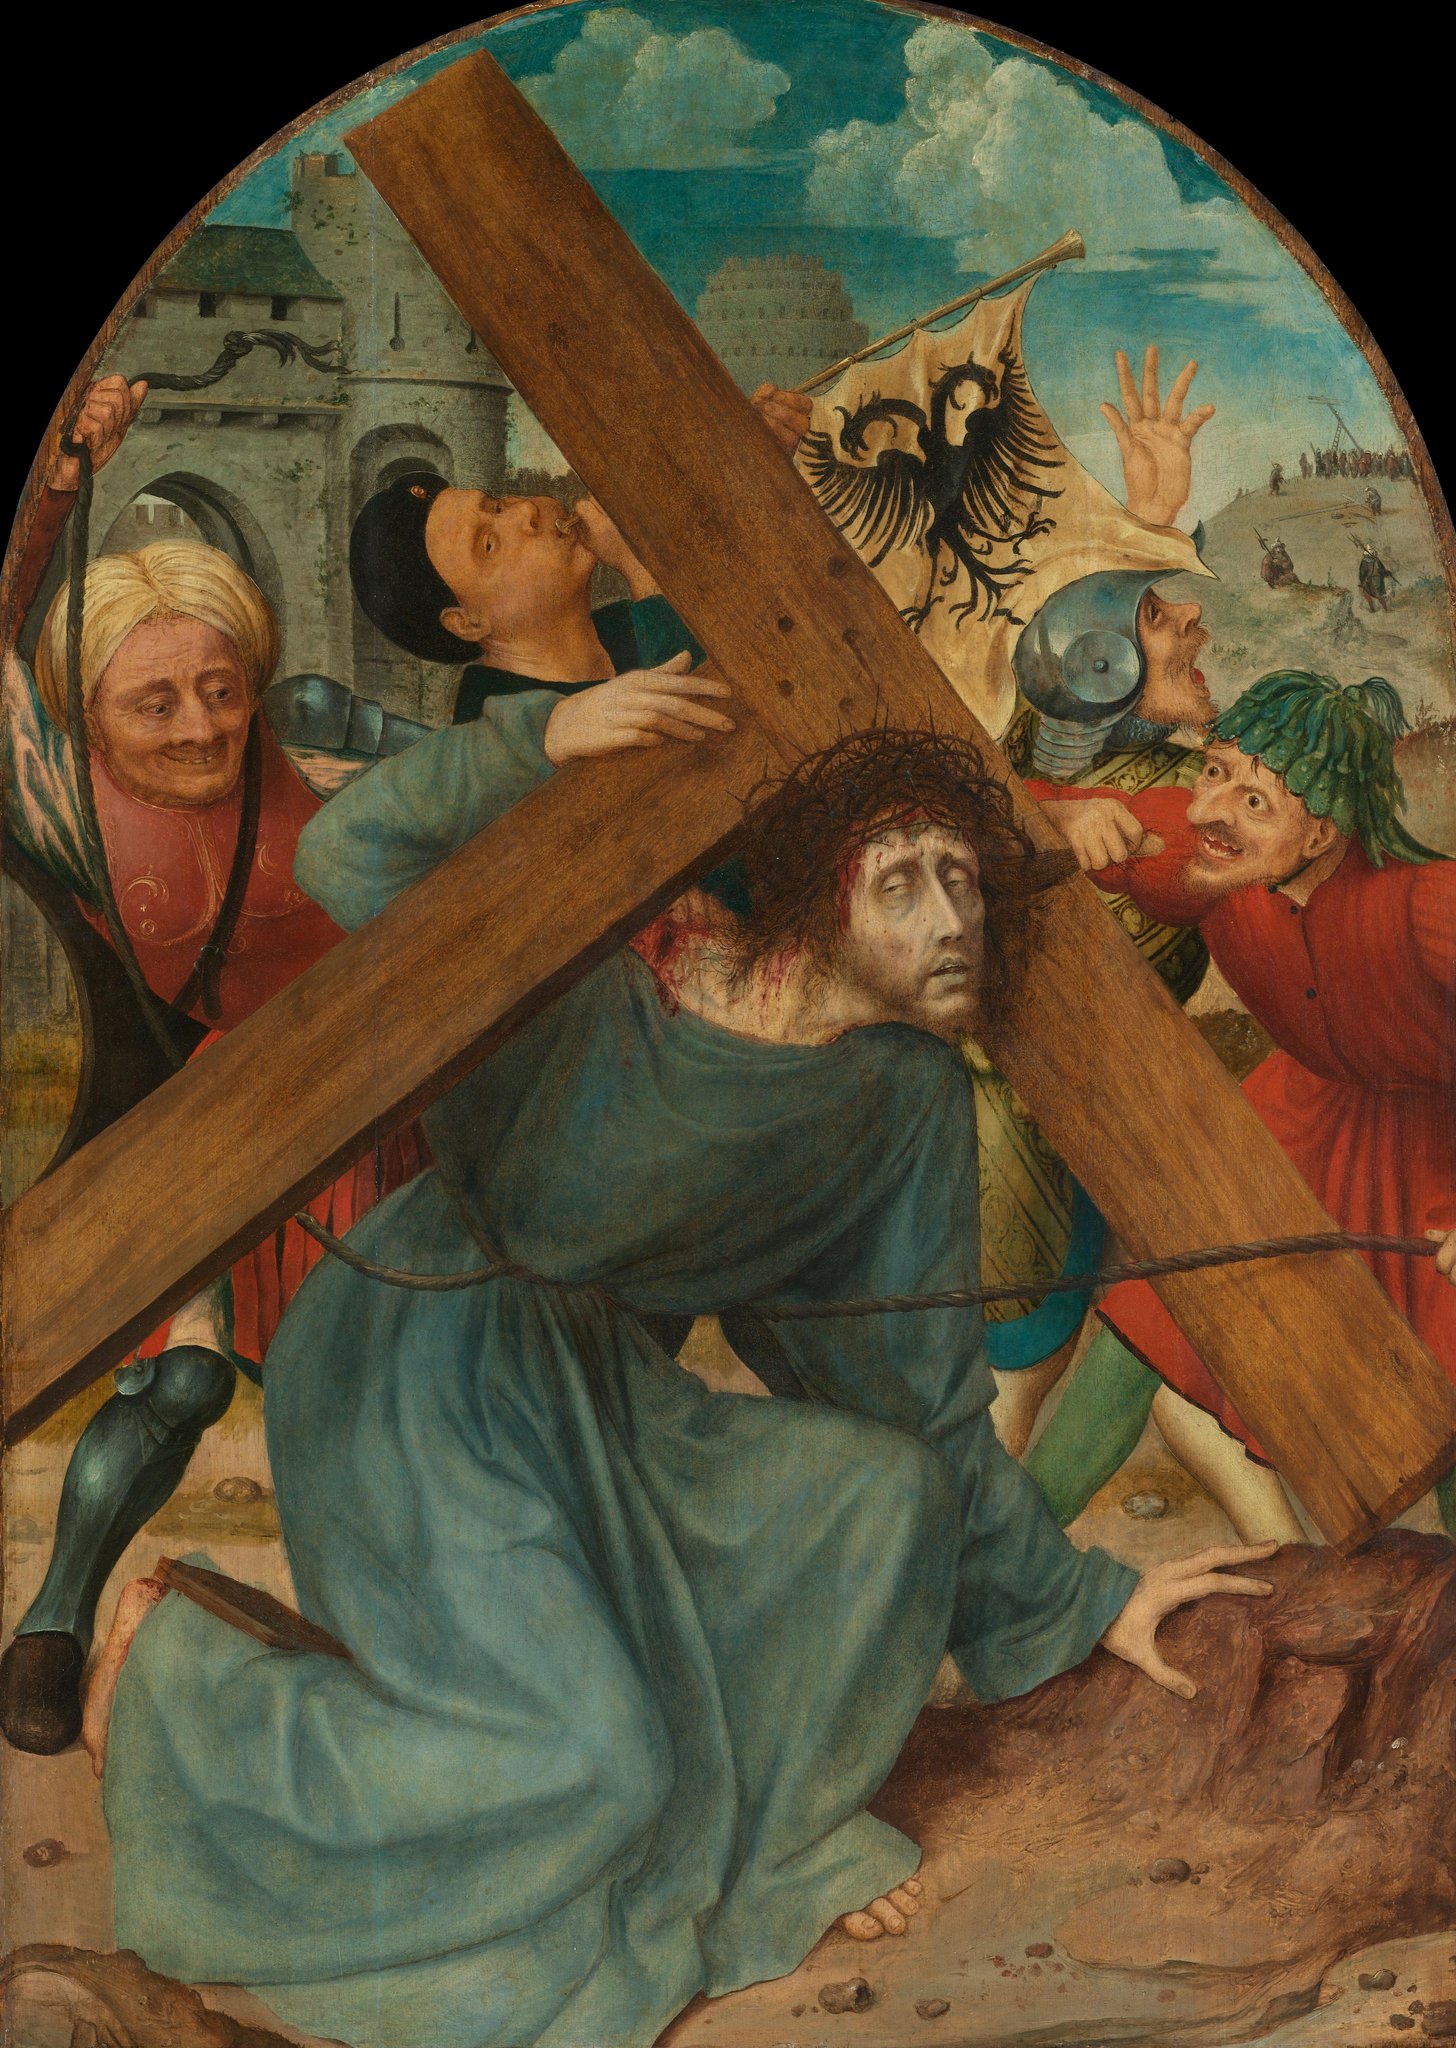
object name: painting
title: Christ Carrying the Cross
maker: quinten massijs (i)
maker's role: draughtsman, painter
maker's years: 1466-1530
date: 1510-1515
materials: oil, panel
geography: antwerp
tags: carrying of the cross: christ bearing the cross, alone or with the help of others (e.g. simon the cyrenian)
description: Here Massijs, a leading artist in early 16th-century Antwerp, paints an intense picture of Jesus’s suffering. Jesus appears close to the foreground, connecting almost tangibly with the viewer: bloodied and bowed under the weight of the cross. This penetrating depiction helped worshippers empathise with Jesus’s pain.